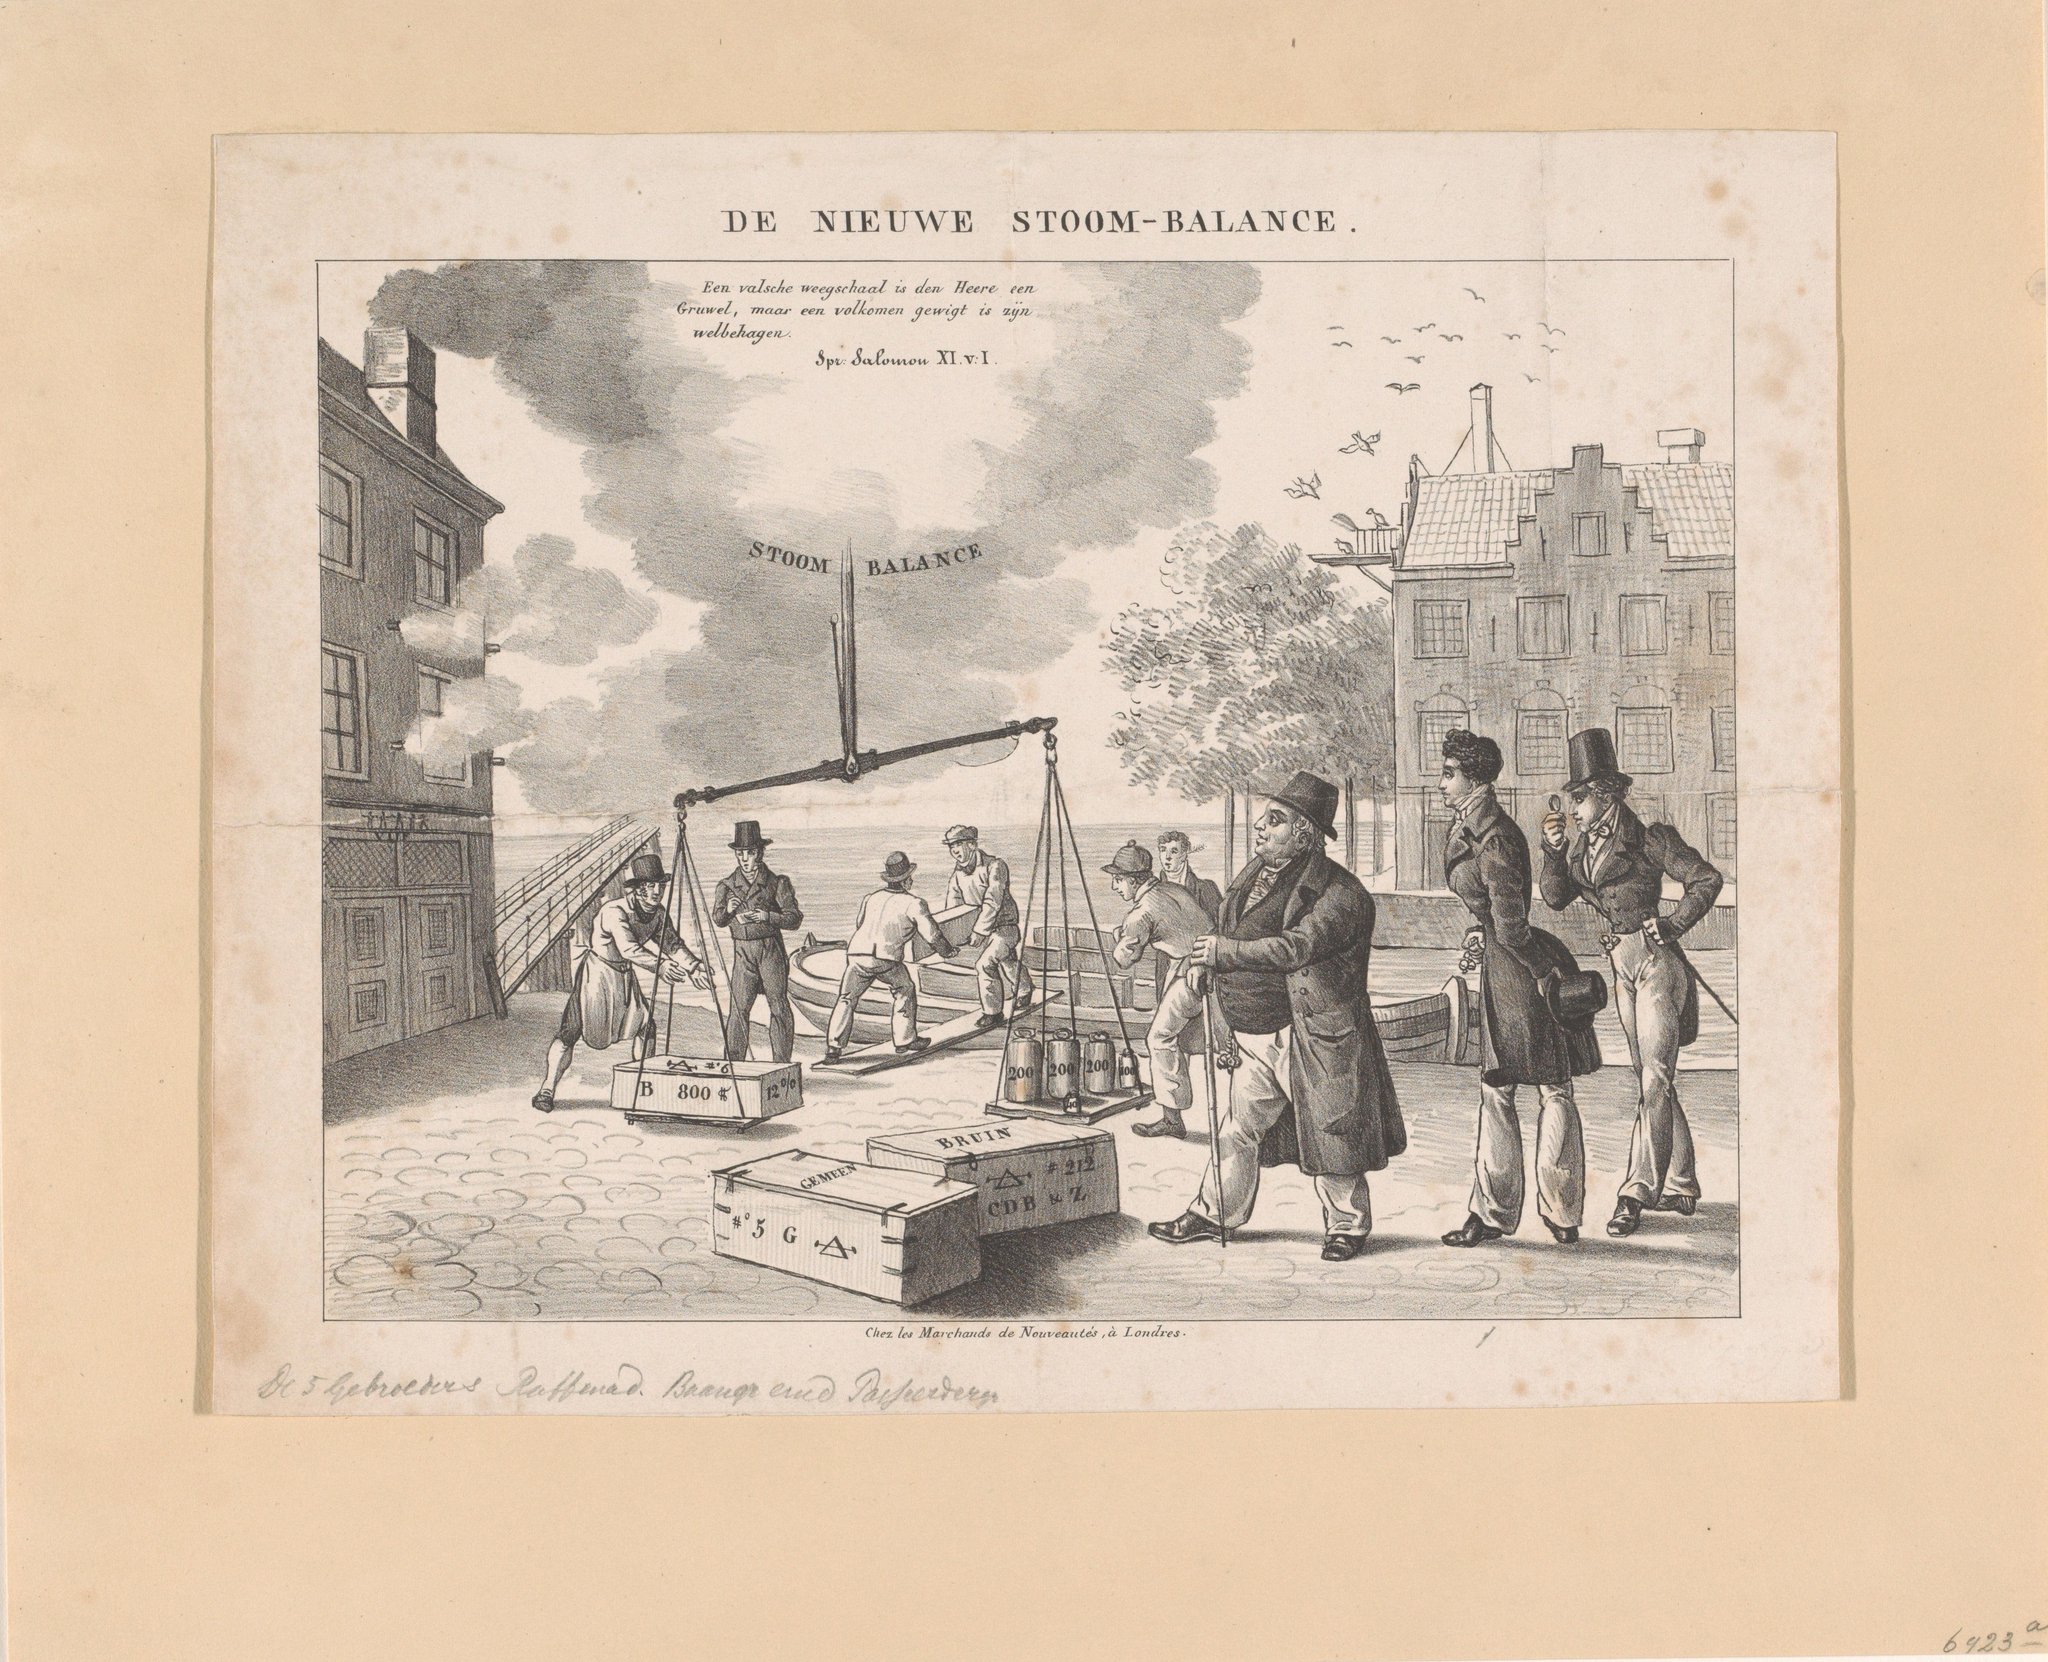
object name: cartoon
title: Spotprent op het bedrog van de firma C. de Bruyn & Zonen, 1834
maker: Anonymous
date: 1834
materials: paper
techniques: lithograph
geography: netherlands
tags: fraudulence, swindling, scales, industries ~ food, drink, stimulants, sugar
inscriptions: collector's mark: Lugt 2228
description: Spotprent op het bedrog met een valse weegschaal van de firma C. de Bruyn & Zonen, 1834. De firma bezat de eerste stoomsuikerraffinaderij aan de Lijnbaansgracht in Amsterdam. Op 8 januari 1834 werden zij betrapt op het gebruik van een balans waarvan een arm was verlengd. Centraal de valse balans hangend aan de stoomwolken die uit de fabriek 'De Vijf Gebroeders' komen en waarop kisten met suiker worden gewogen. Rechts C. de Bruyn met zijn twee zoons. In de wolken een bijbelcitaat.